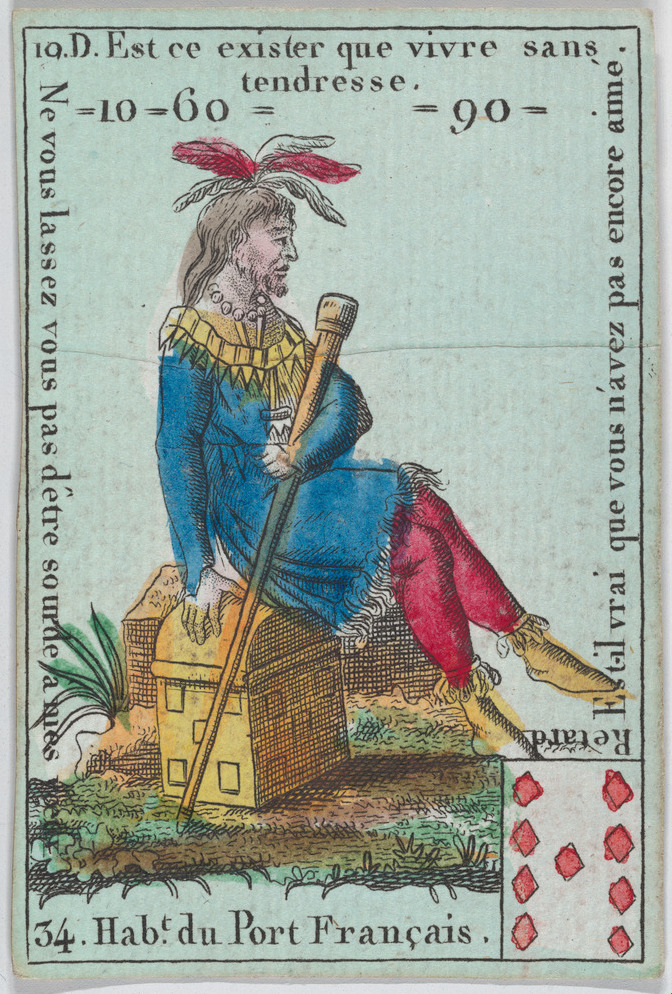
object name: print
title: Hab.t du Port Francais from playing cards "Jeu d'Or"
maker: anonymous, french, 18th century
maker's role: artist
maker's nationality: french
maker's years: 1700-1800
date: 1700-1799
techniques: etching, hand coloring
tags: men,profiles,playing cards